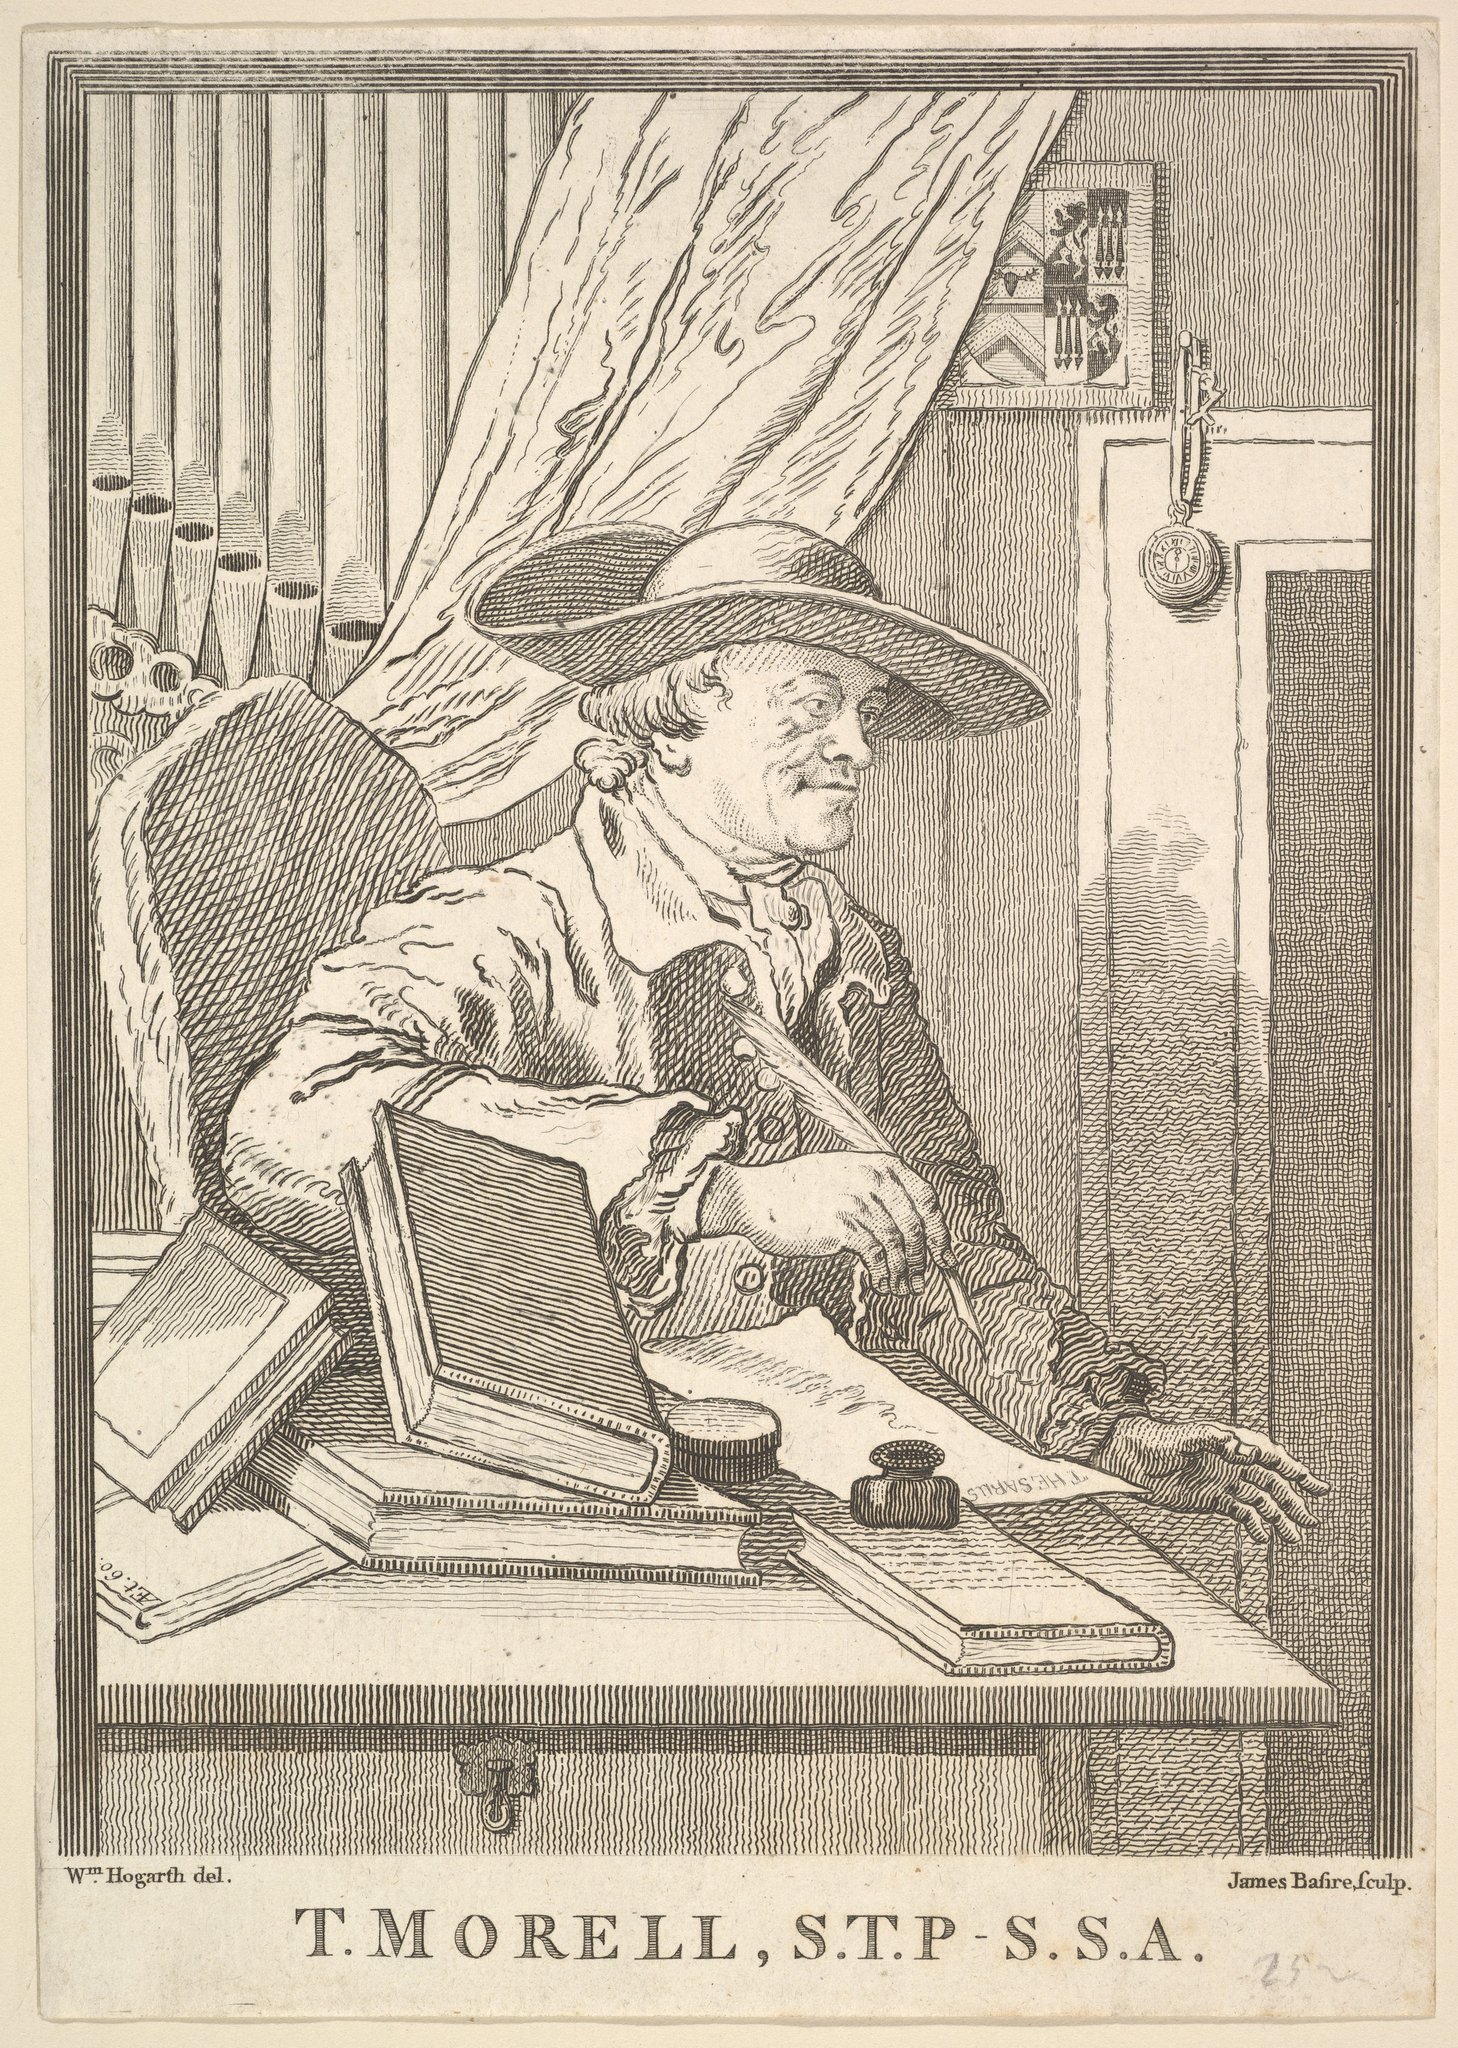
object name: print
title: Thomas Morell, S.T.P.- S.S.A.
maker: james basire, the elder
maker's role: engraver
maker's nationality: british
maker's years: 1730-1802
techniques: engraving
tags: books,men,writing